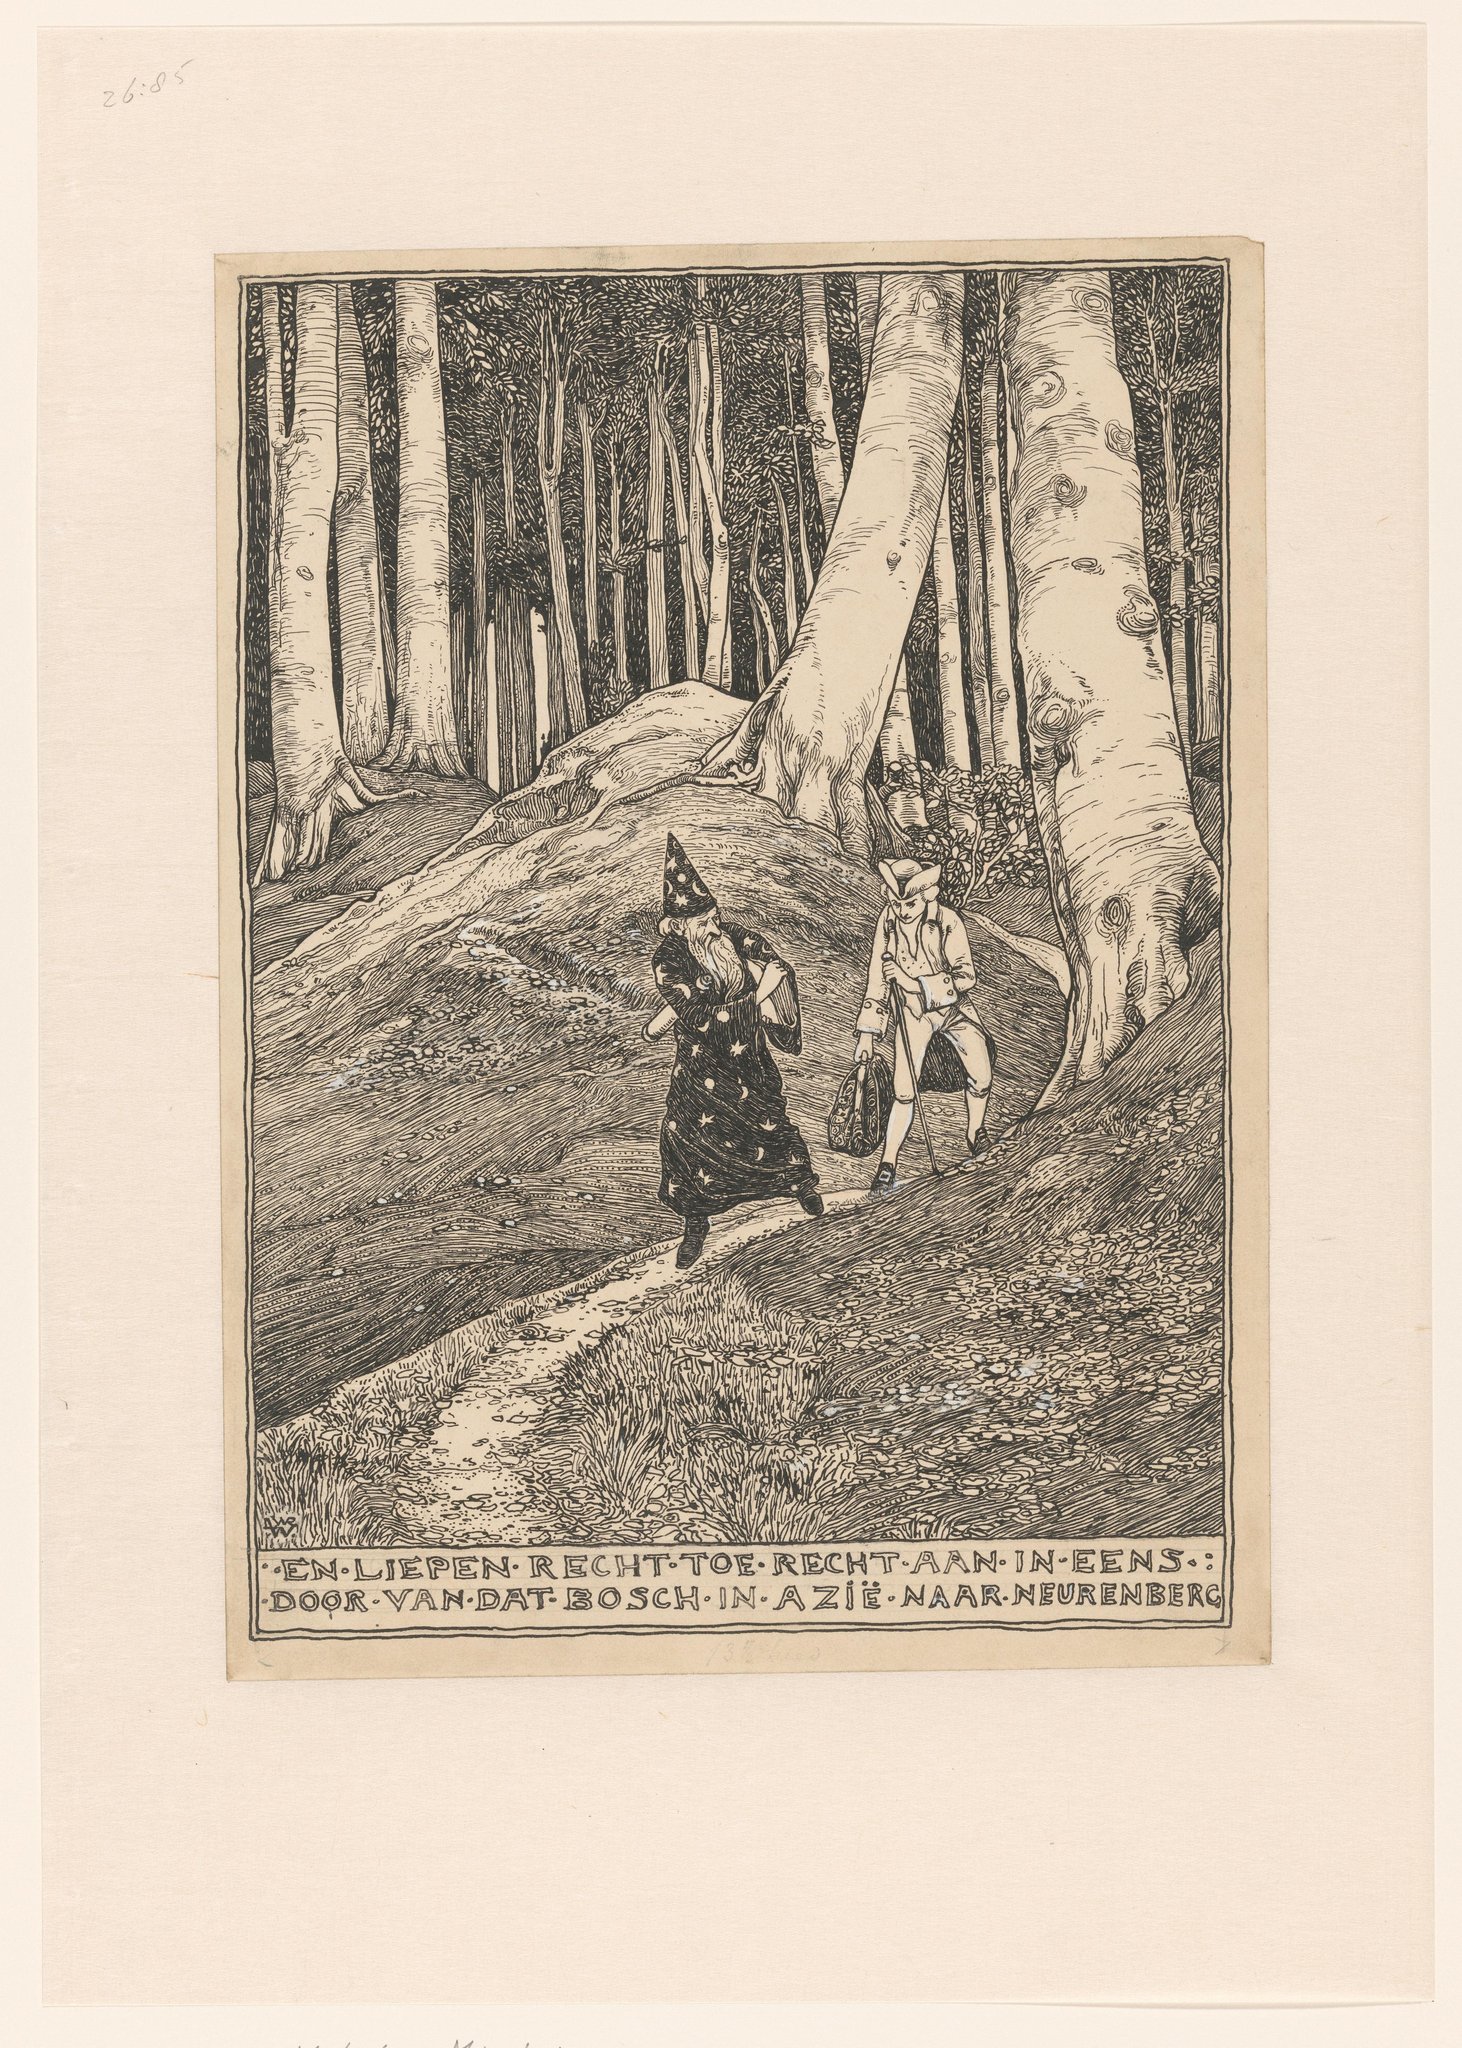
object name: drawing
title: En liepen recht toe recht aan in eens door van dat bosch in Azië naar Neurenberg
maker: willem wenckebach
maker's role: designer, draughtsman, painter, print maker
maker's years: 1860-1937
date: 1898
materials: paint, ink, paper, pencil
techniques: brush, pen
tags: forest path or lane, 'en route', traveller under way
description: De sterrenkundige loopt voorop en draagt een gewaad met een patroon van sterren. Op zijn hoofd heeft hij een puntmuts, eveneens met sterrenmotief. Christiaan Drosselmeier volgt met een tas en staf.